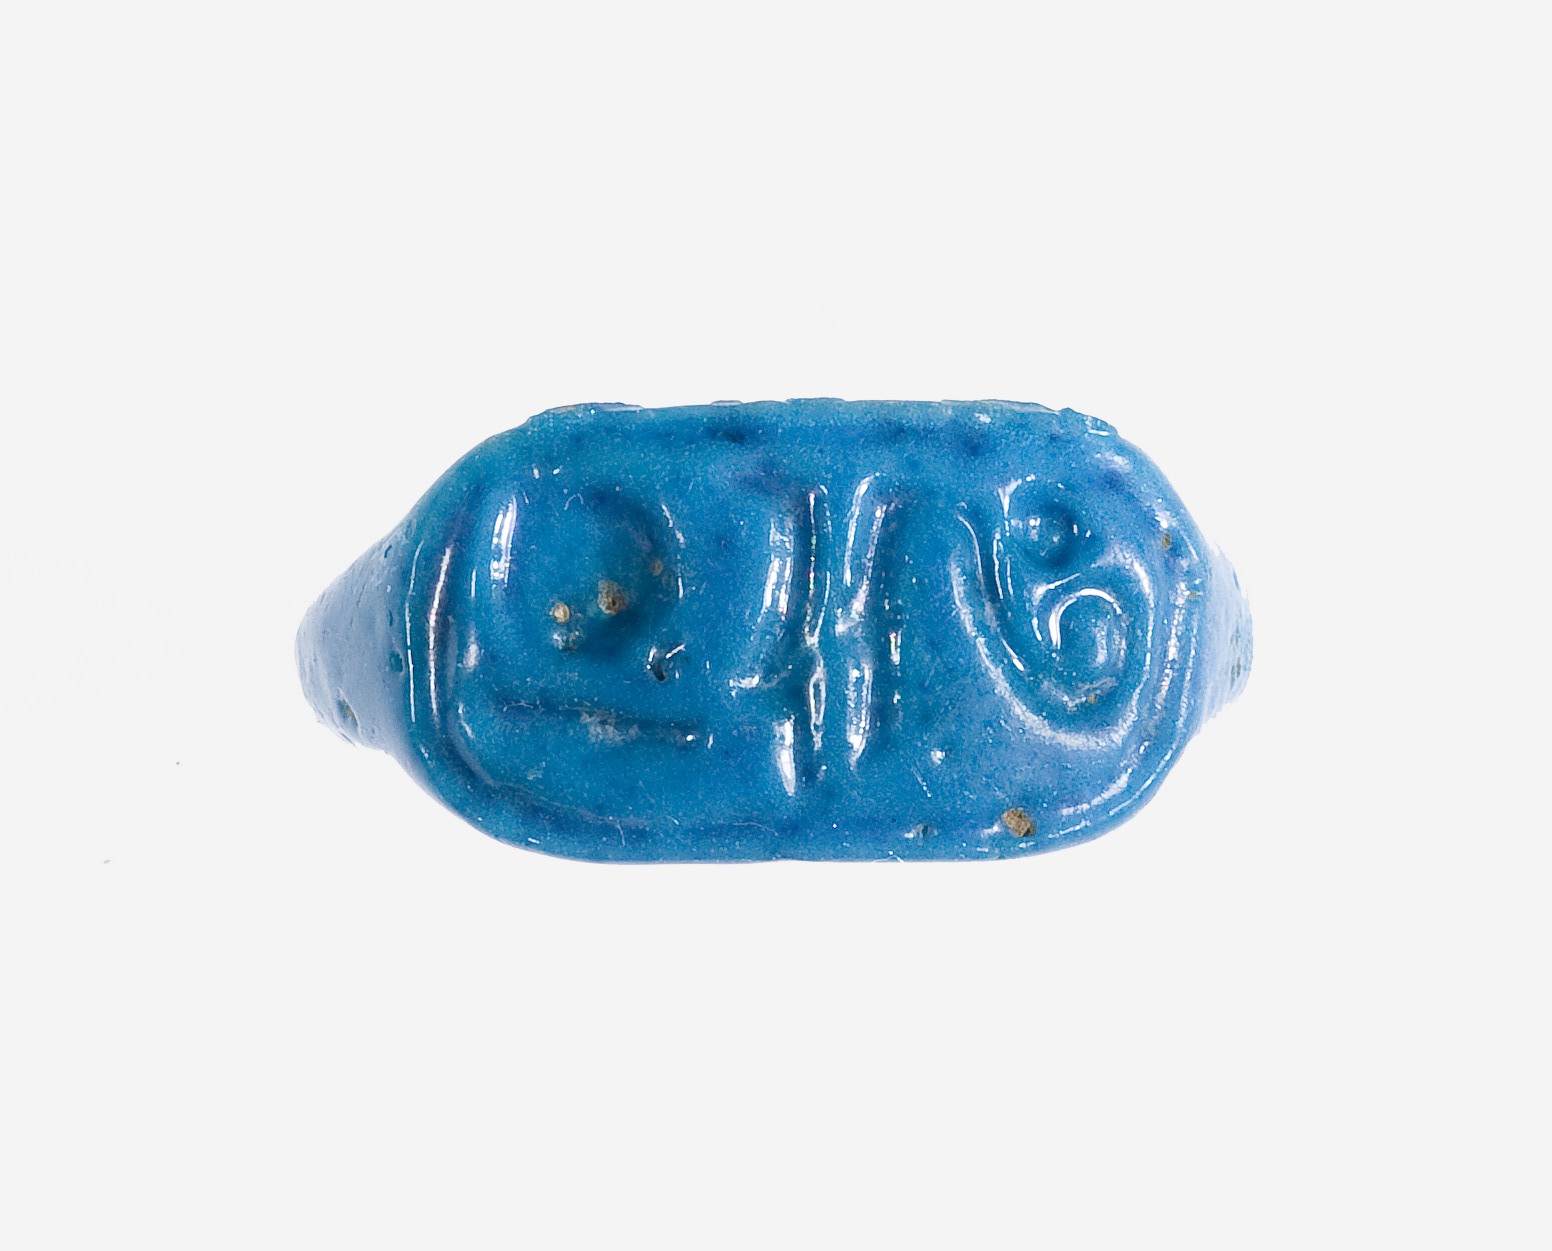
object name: ring, amenhotep iii, nebmaatre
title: Ring Inscribed with the Throne Name of Amenhotep III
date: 1390-1352 BCE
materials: faience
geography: egypt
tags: hieroglyphs